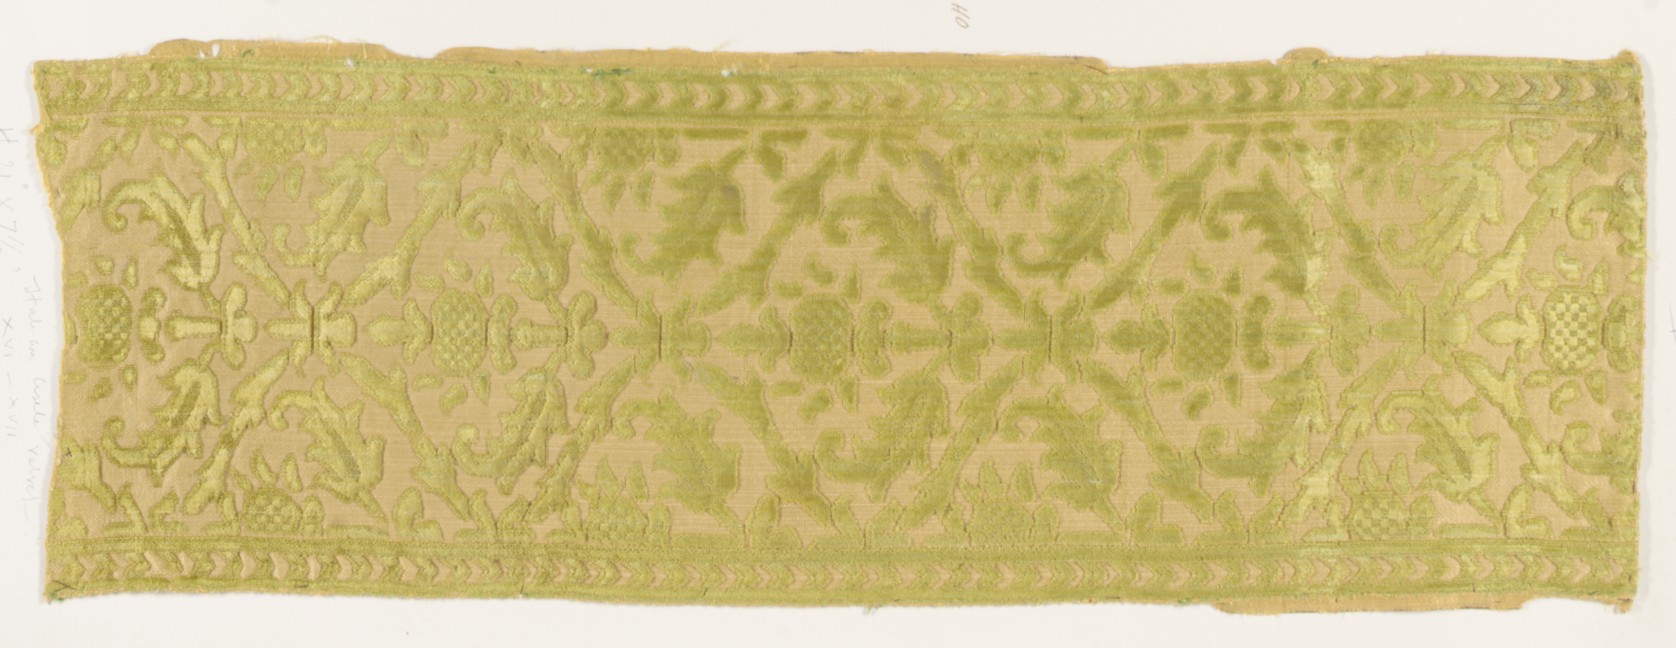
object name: fragment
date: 1501-1700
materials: silk